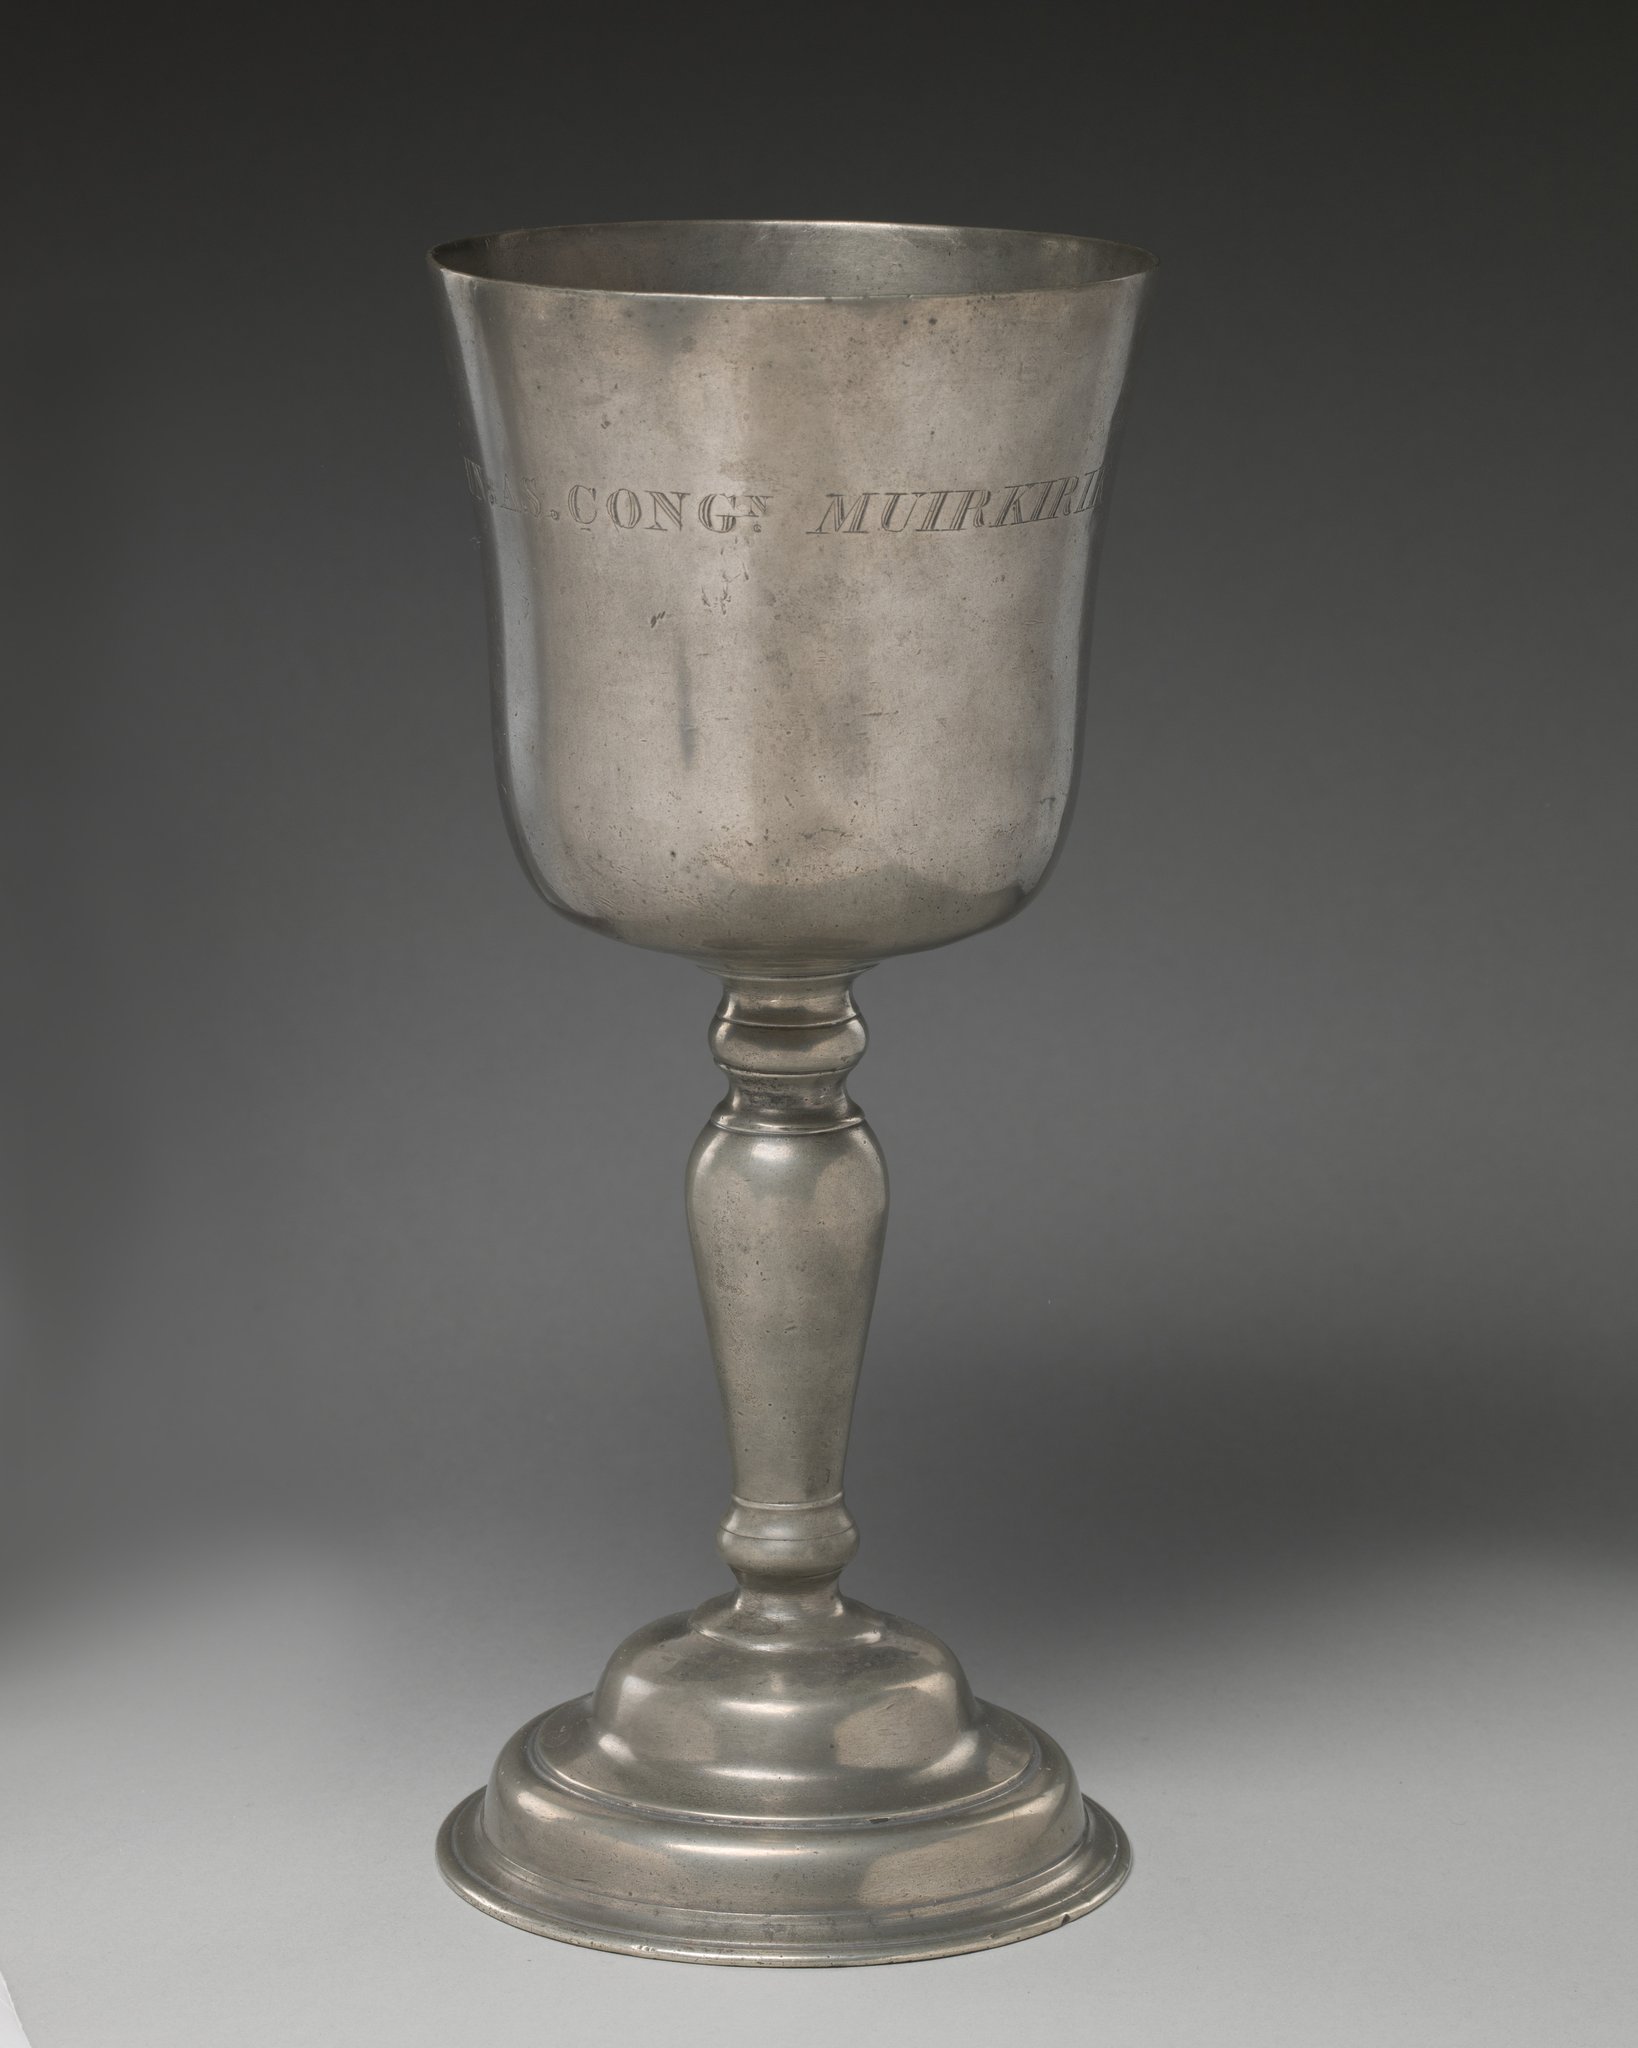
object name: chalice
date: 1770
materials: pewter